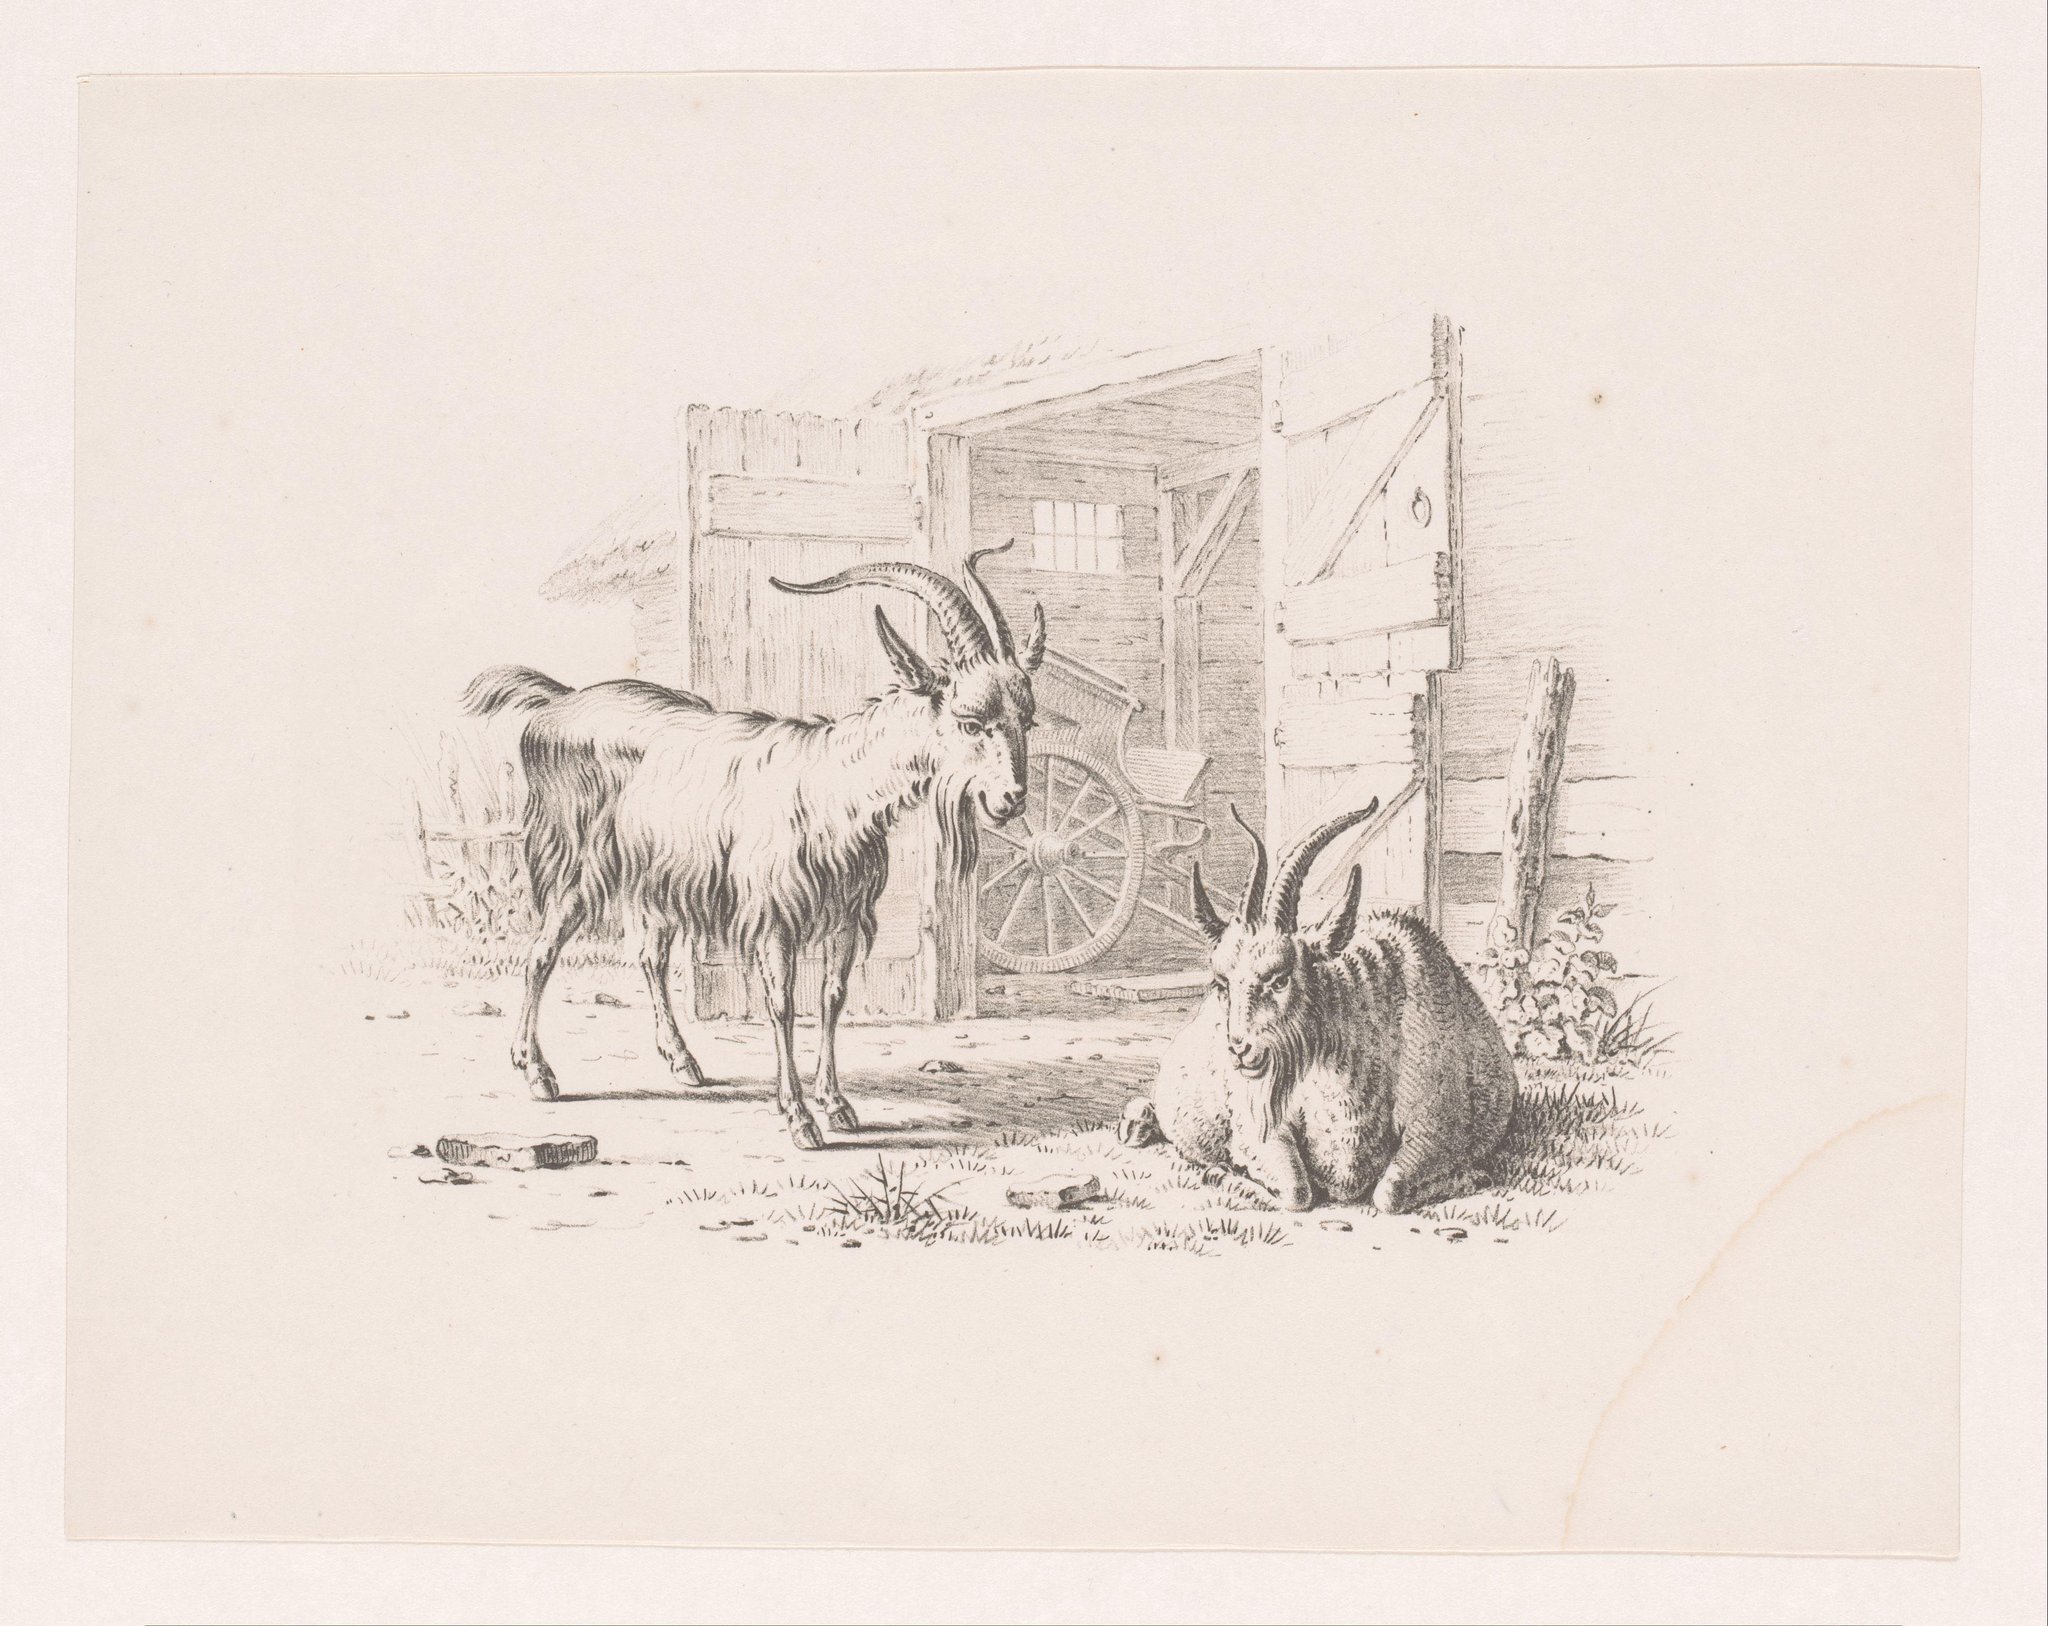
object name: print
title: Twee bokken voor een schuur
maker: pieter de goeje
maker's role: draughtsman, print maker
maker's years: 1789-1859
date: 1809-1859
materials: paper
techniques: lithograph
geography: netherlands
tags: barn, two-wheeled, animal-drawn vehicle, he-goat, billy-goat, goat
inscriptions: collector's mark: Lugt 2228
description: Een bok staat, de ander ligt op de grond. De deur van de schuur staat open, daarbinnen staat een rijtuig.